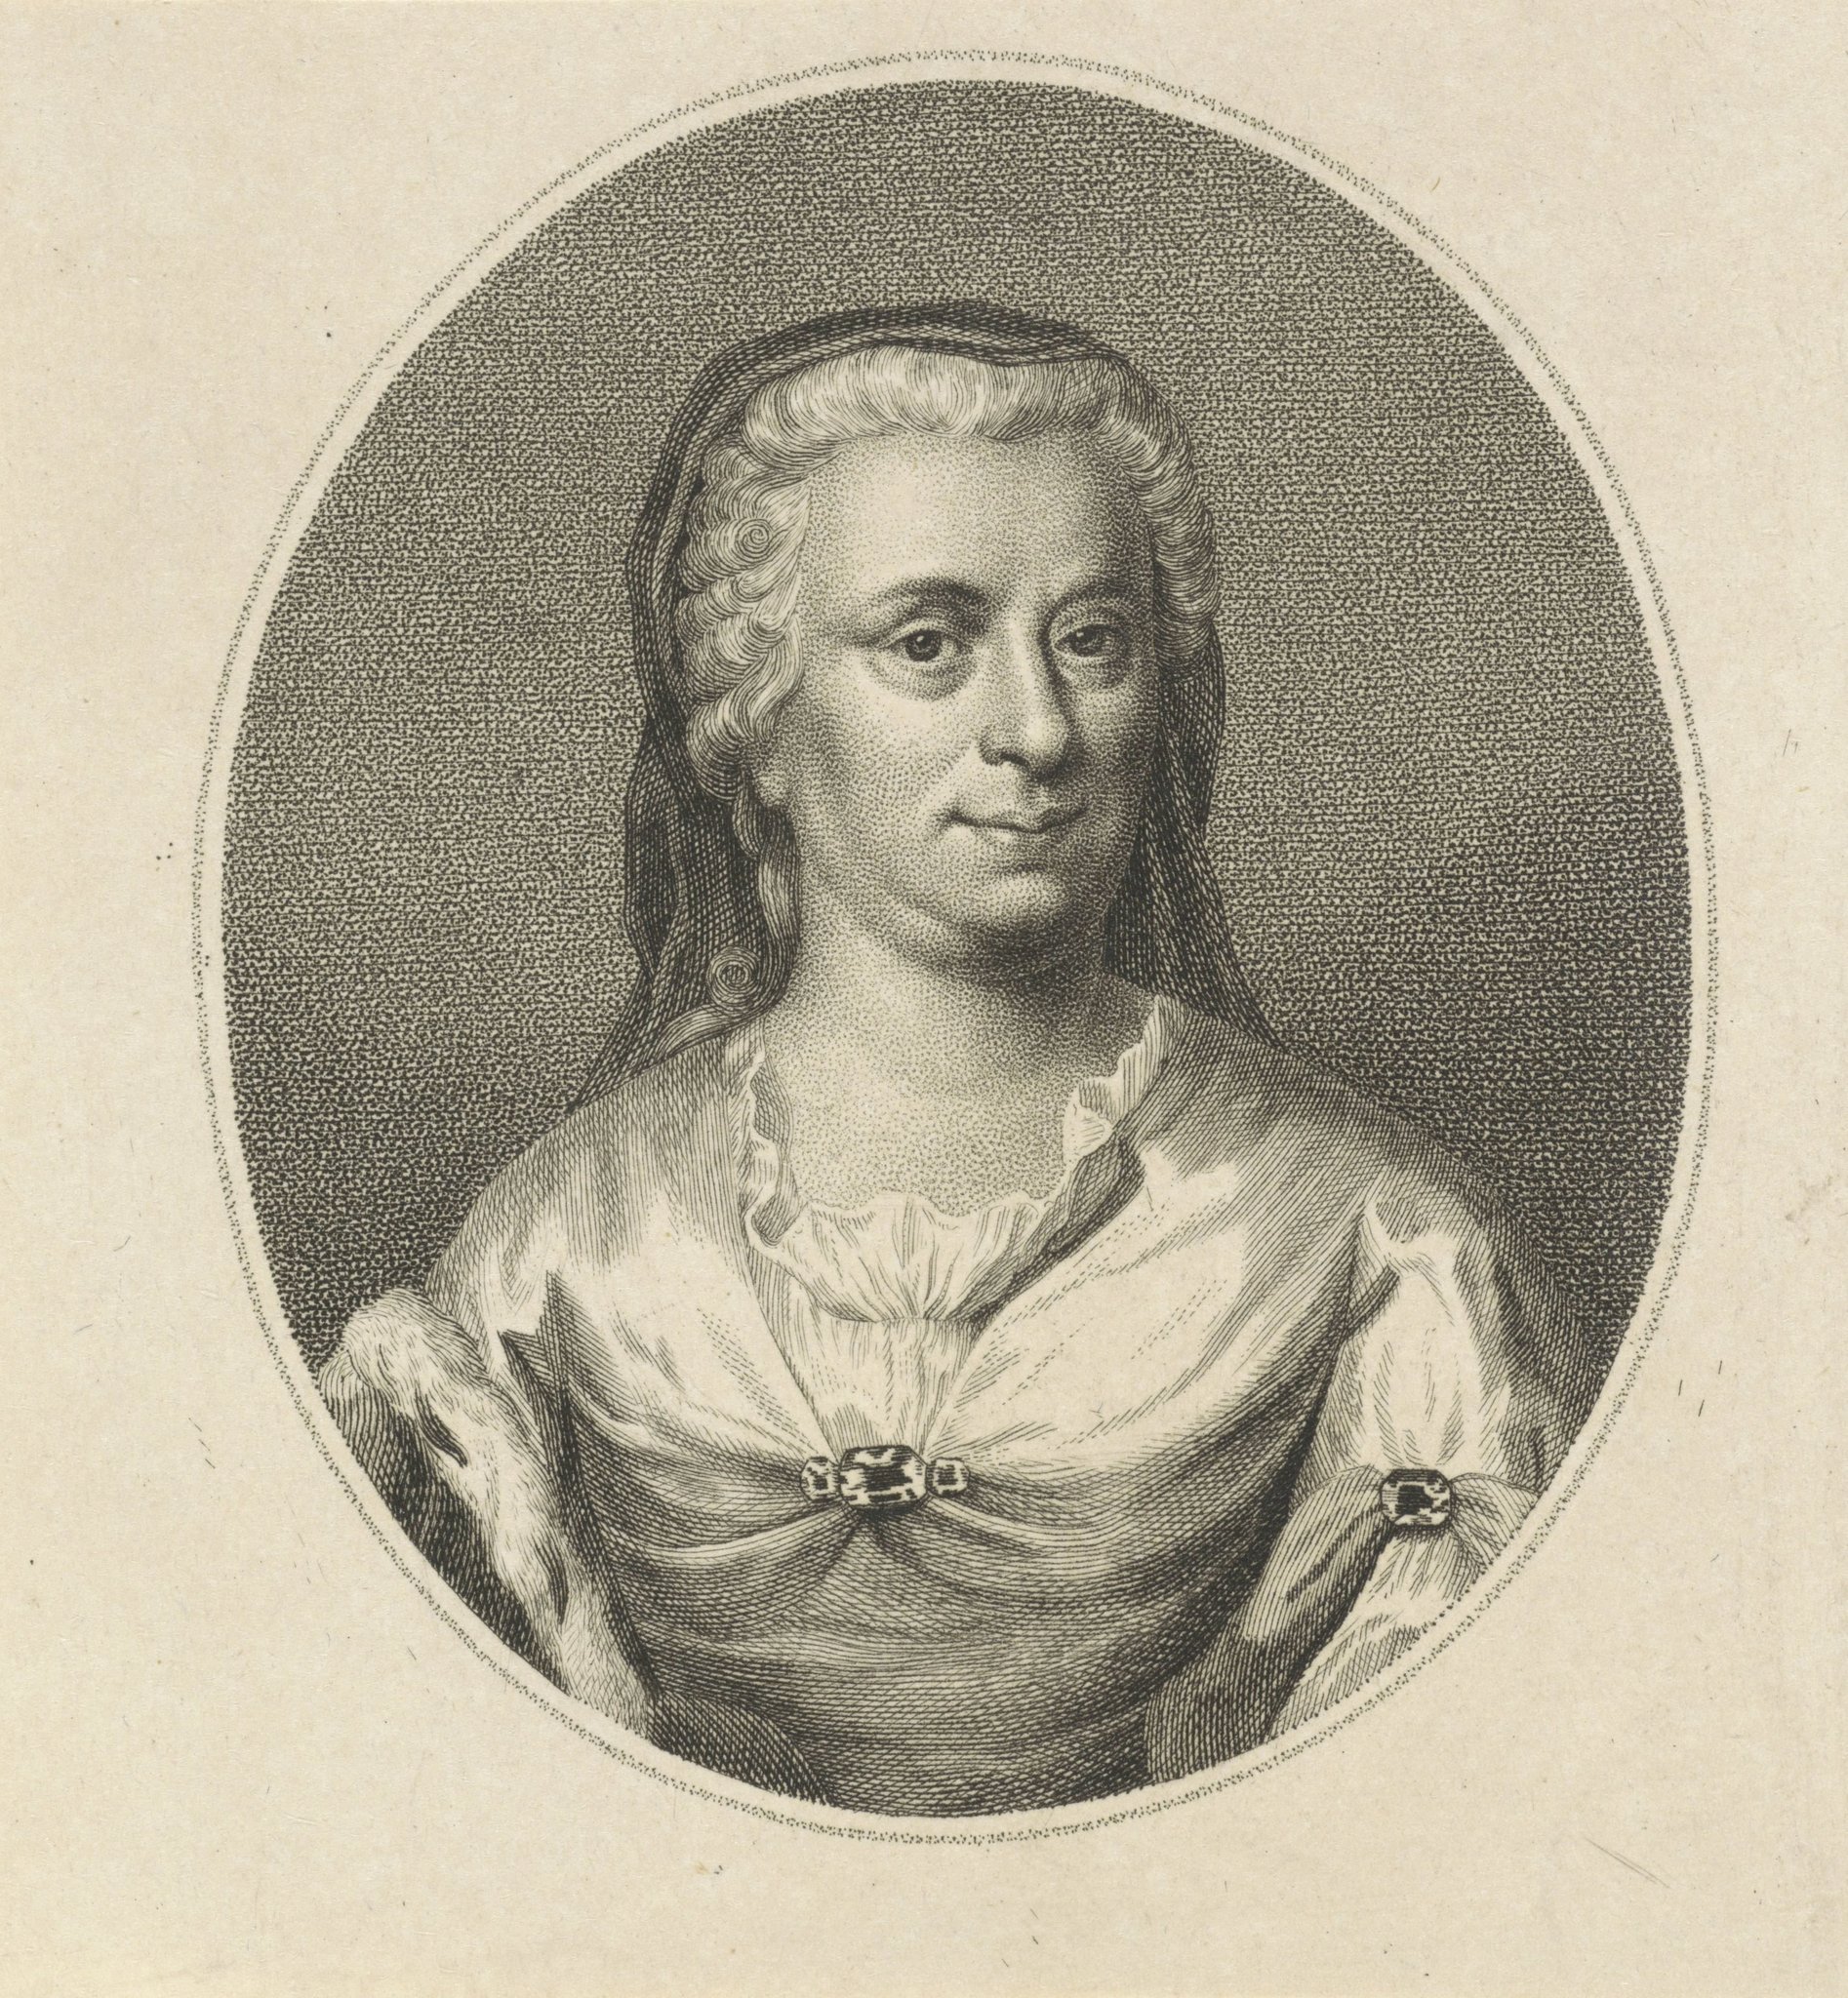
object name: print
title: Portret van Maria Louisa van Hessen-Kassel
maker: willem van senus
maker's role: painter, print maker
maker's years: 1773-1851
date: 1787-1834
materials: paper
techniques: engraving, etching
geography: northern netherlands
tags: leeuwarden, maria louisa van hessen-kassel